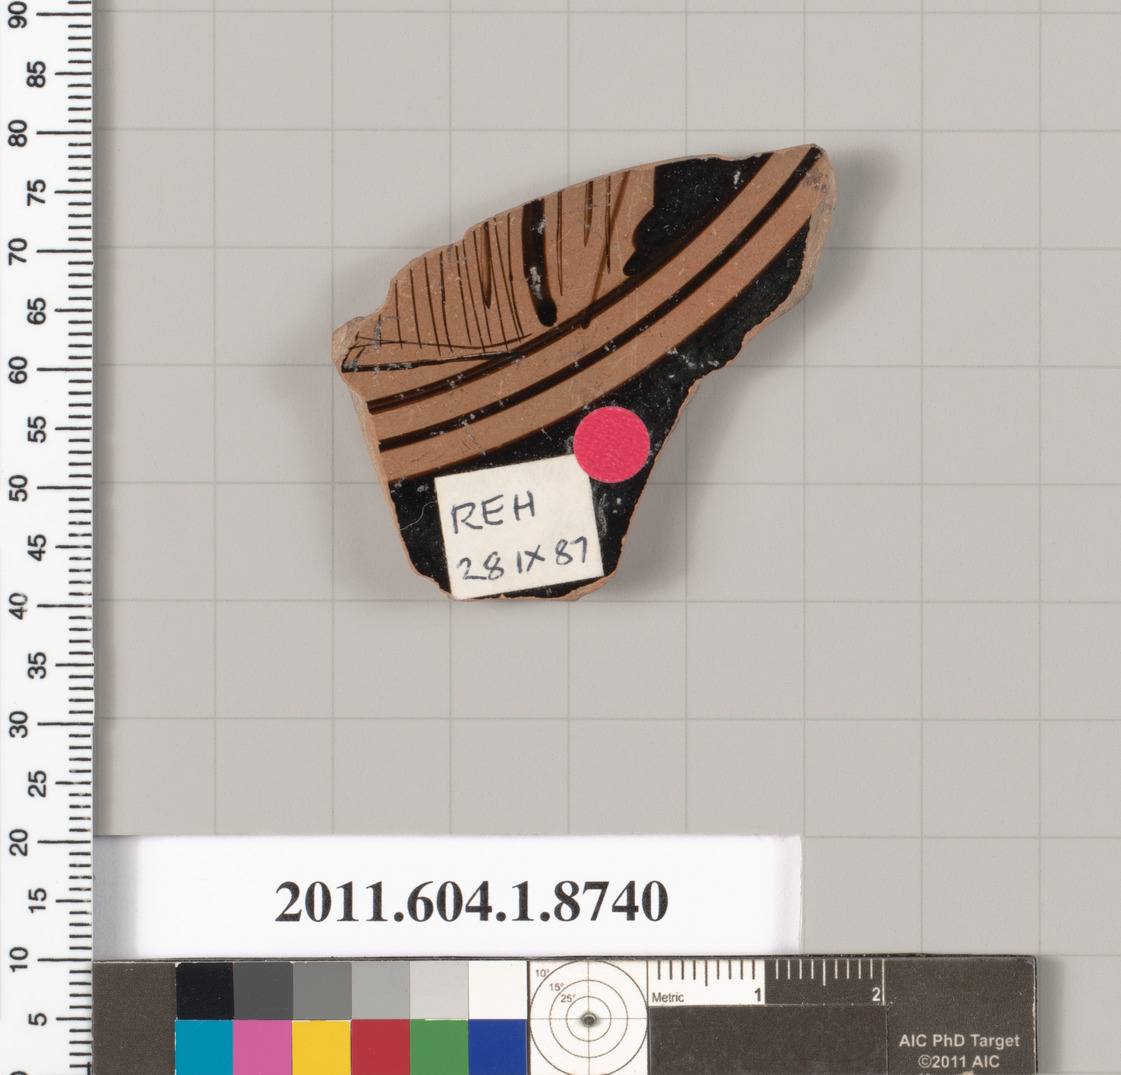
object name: kylix fragment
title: Terracotta fragment of a stemless cup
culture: greek, attic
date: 450-426 BCE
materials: terracotta